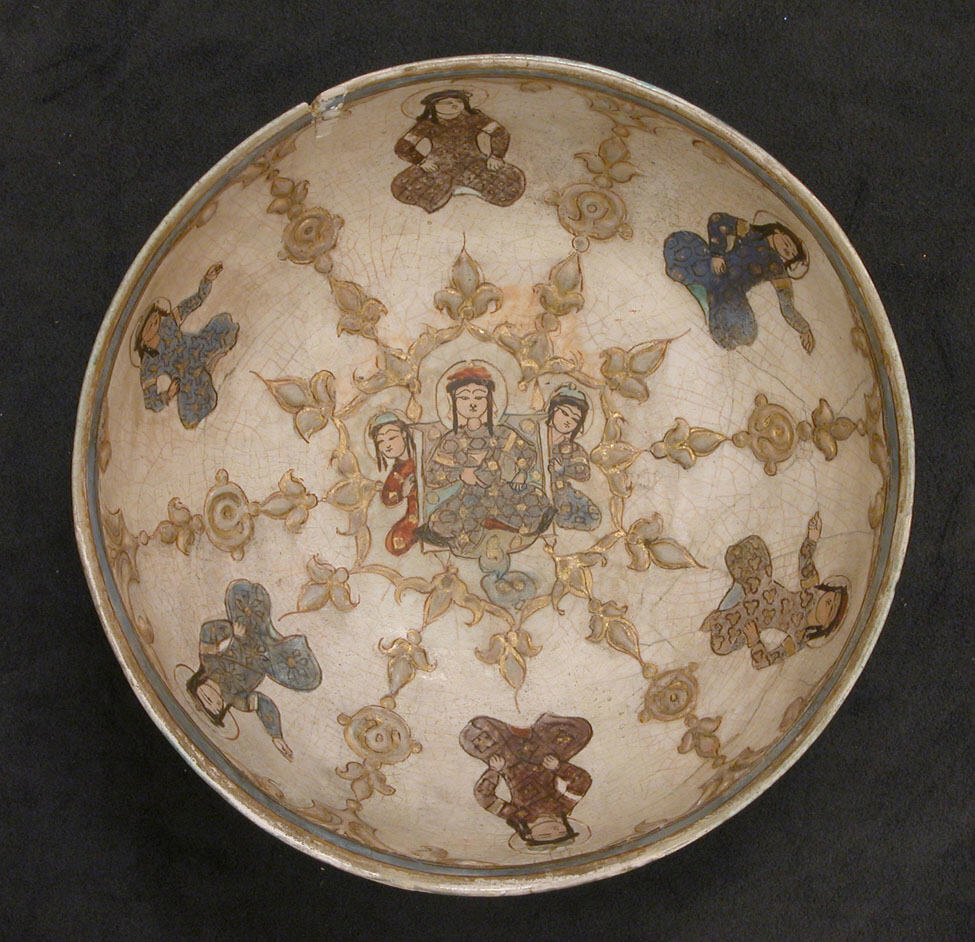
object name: bowl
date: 1101-1300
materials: stonepaste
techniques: overglaze, painting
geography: iran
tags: human figures